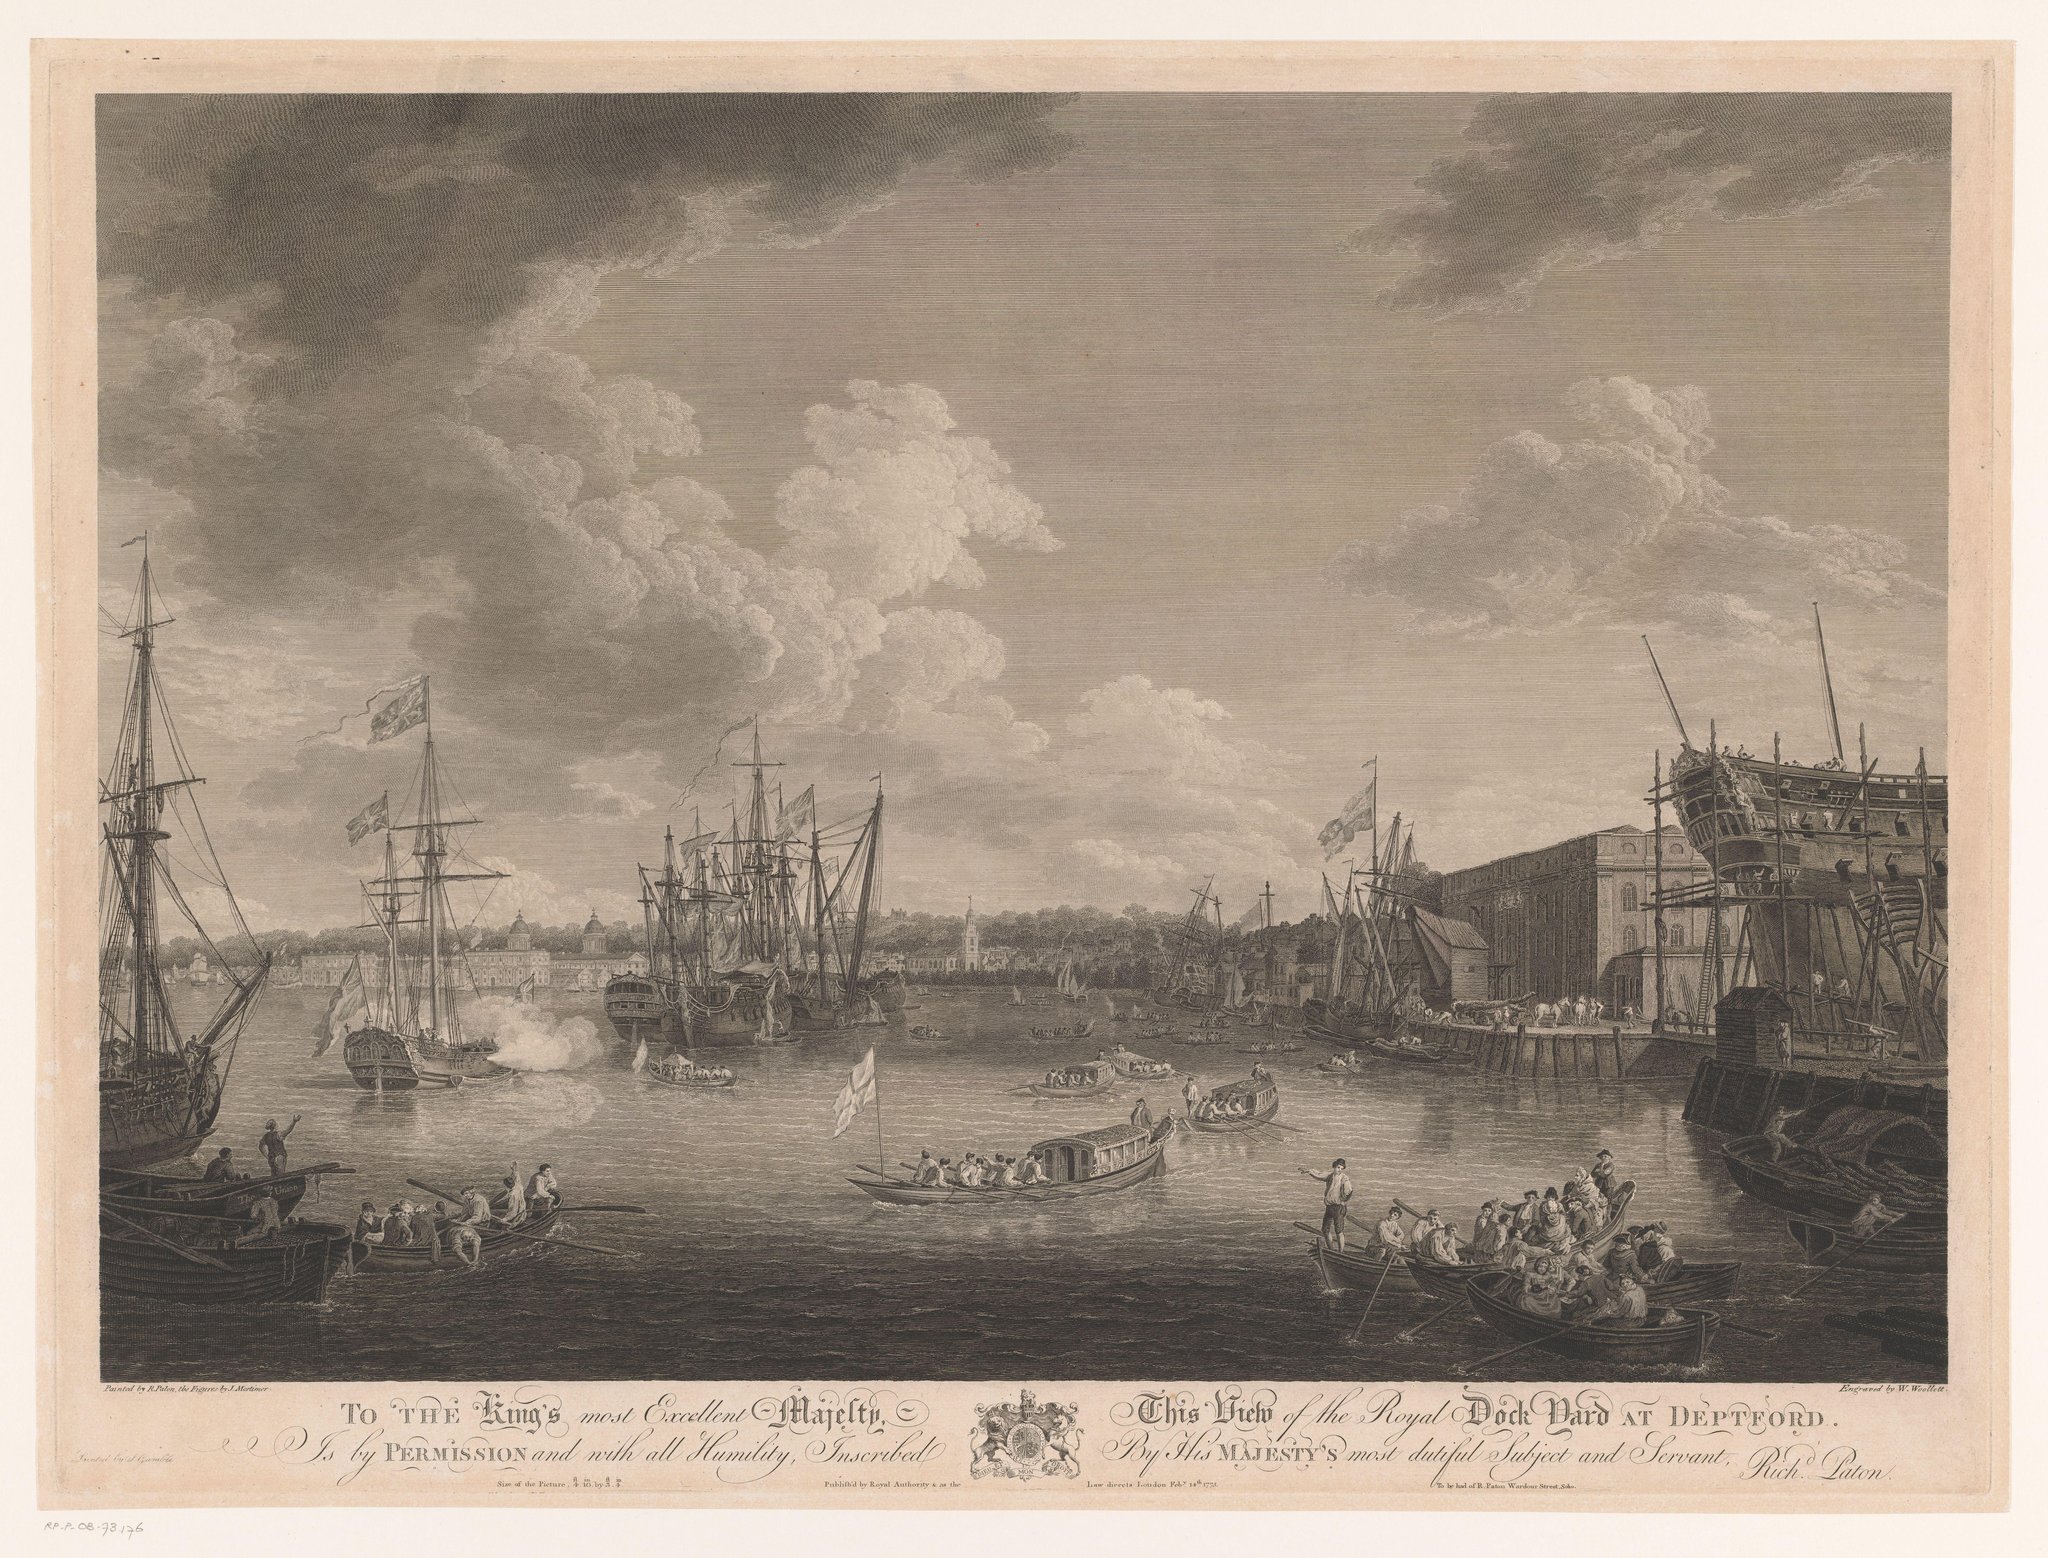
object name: print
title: (...) View of the Royal Dock Yark at Deptford (...)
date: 1702-1775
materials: paper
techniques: engraving, etching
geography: england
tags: rowing-boat, canoe, etc., shipyard-workers, dry-dock, floating-dock, shipyard, shipdock - cc - more than one ship, deptford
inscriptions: collector's mark: Lugt 12